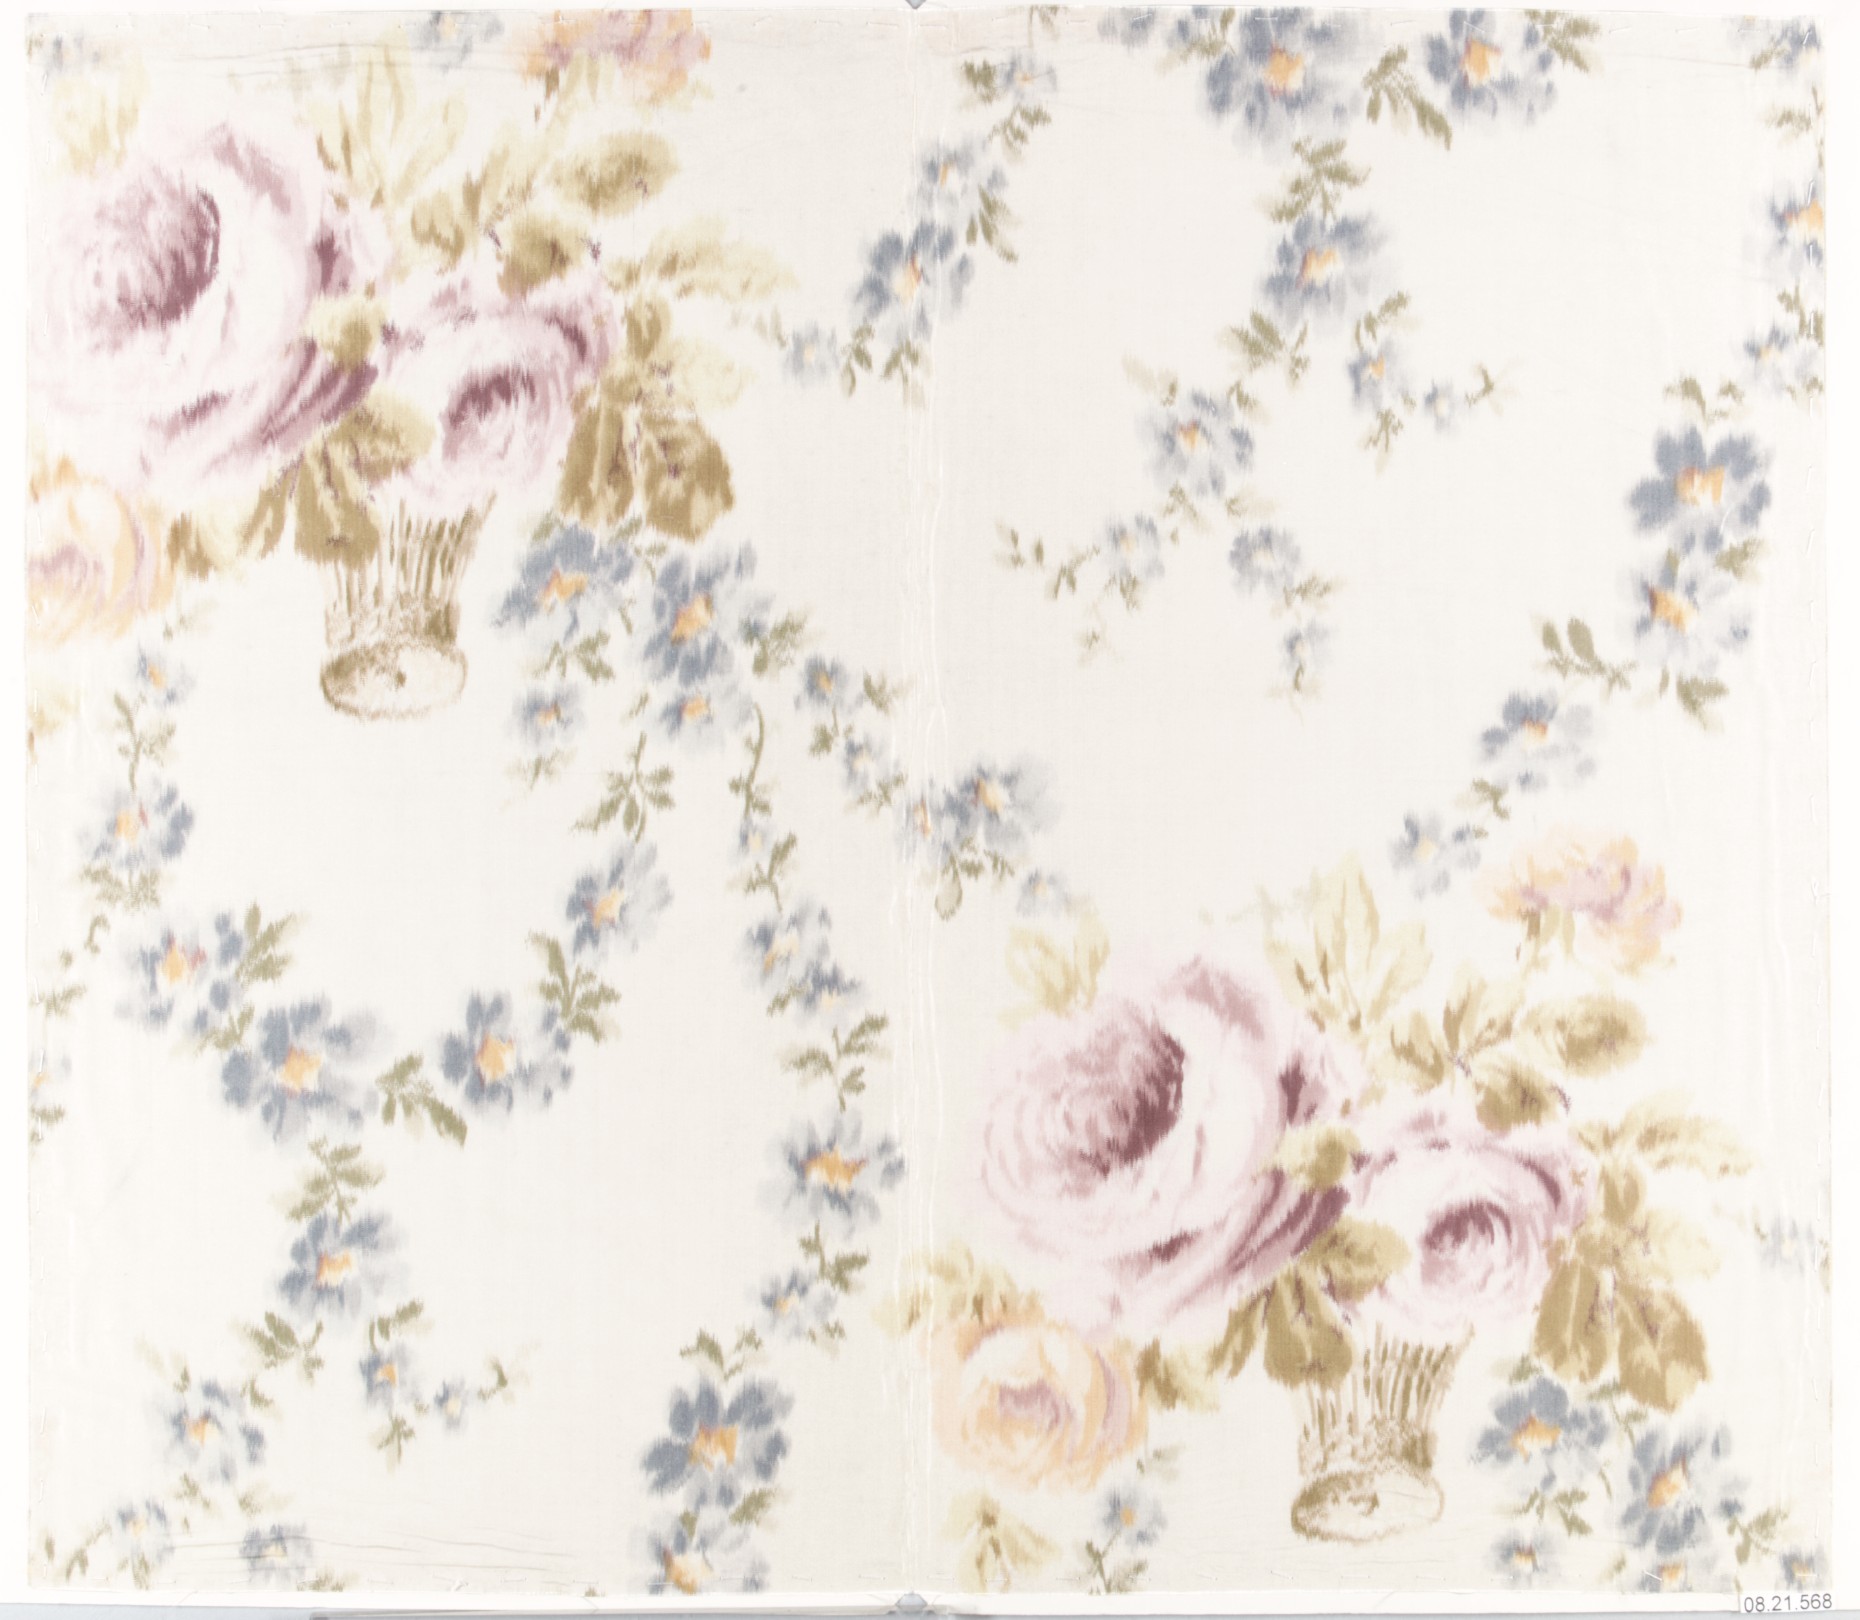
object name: textile sample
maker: Anonymous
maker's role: designer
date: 1900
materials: silk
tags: flowers